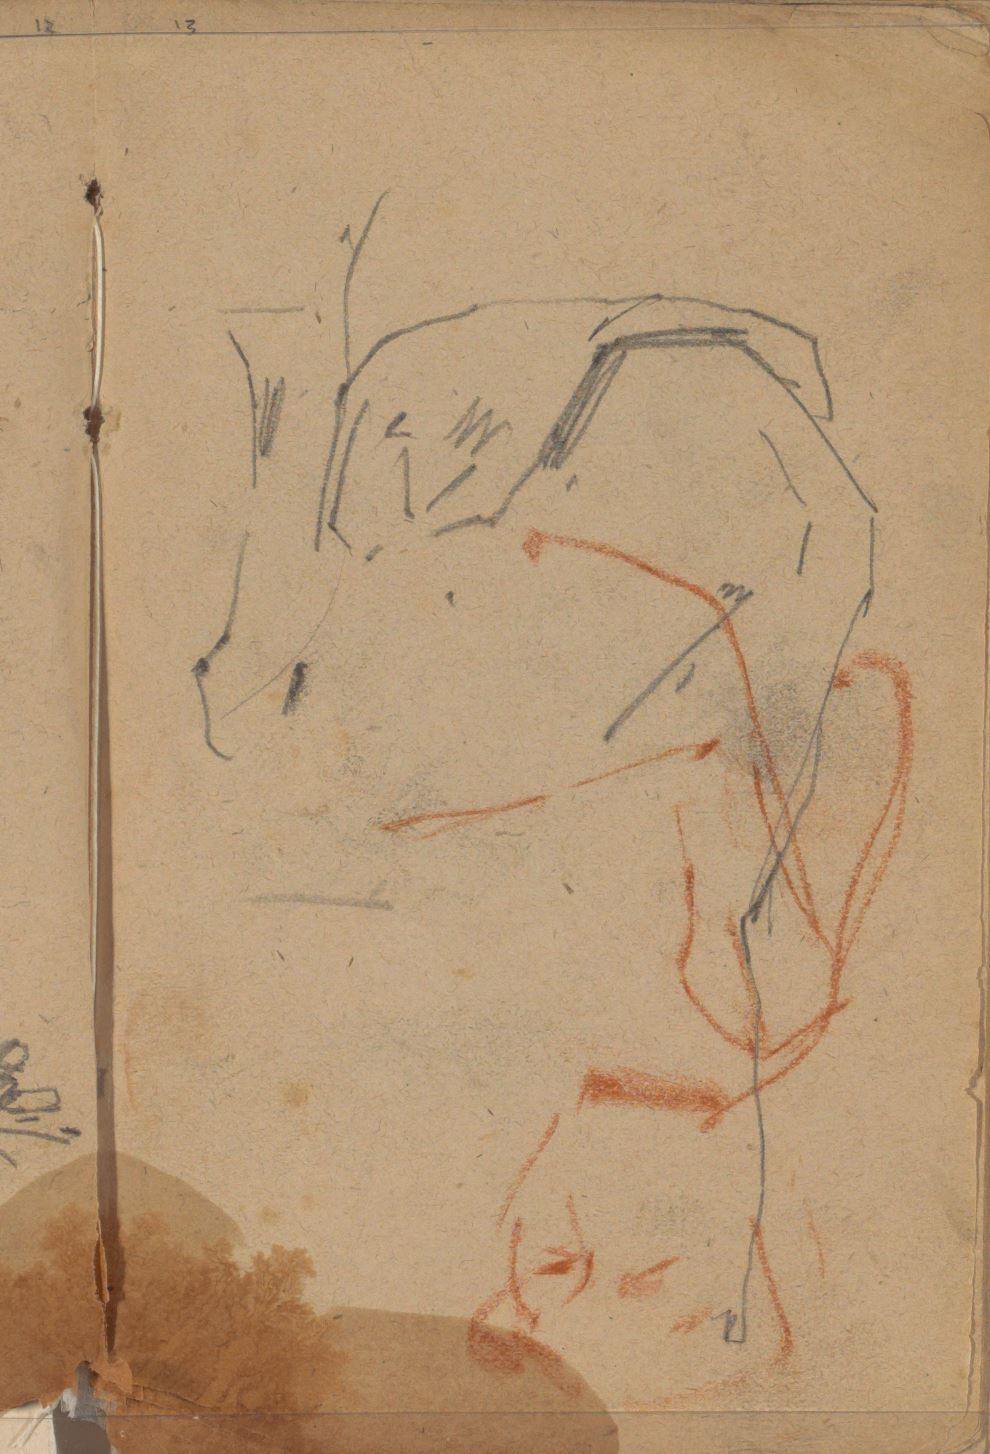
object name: sketchbook leaf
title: Studieblad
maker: george hendrik breitner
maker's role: draughtsman, painter, print maker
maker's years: 1857-1923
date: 1881-1883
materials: chalk, paper, pencil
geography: south holland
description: Studieblad. Pagina 13 uit een schetsboek met 70 bladen.